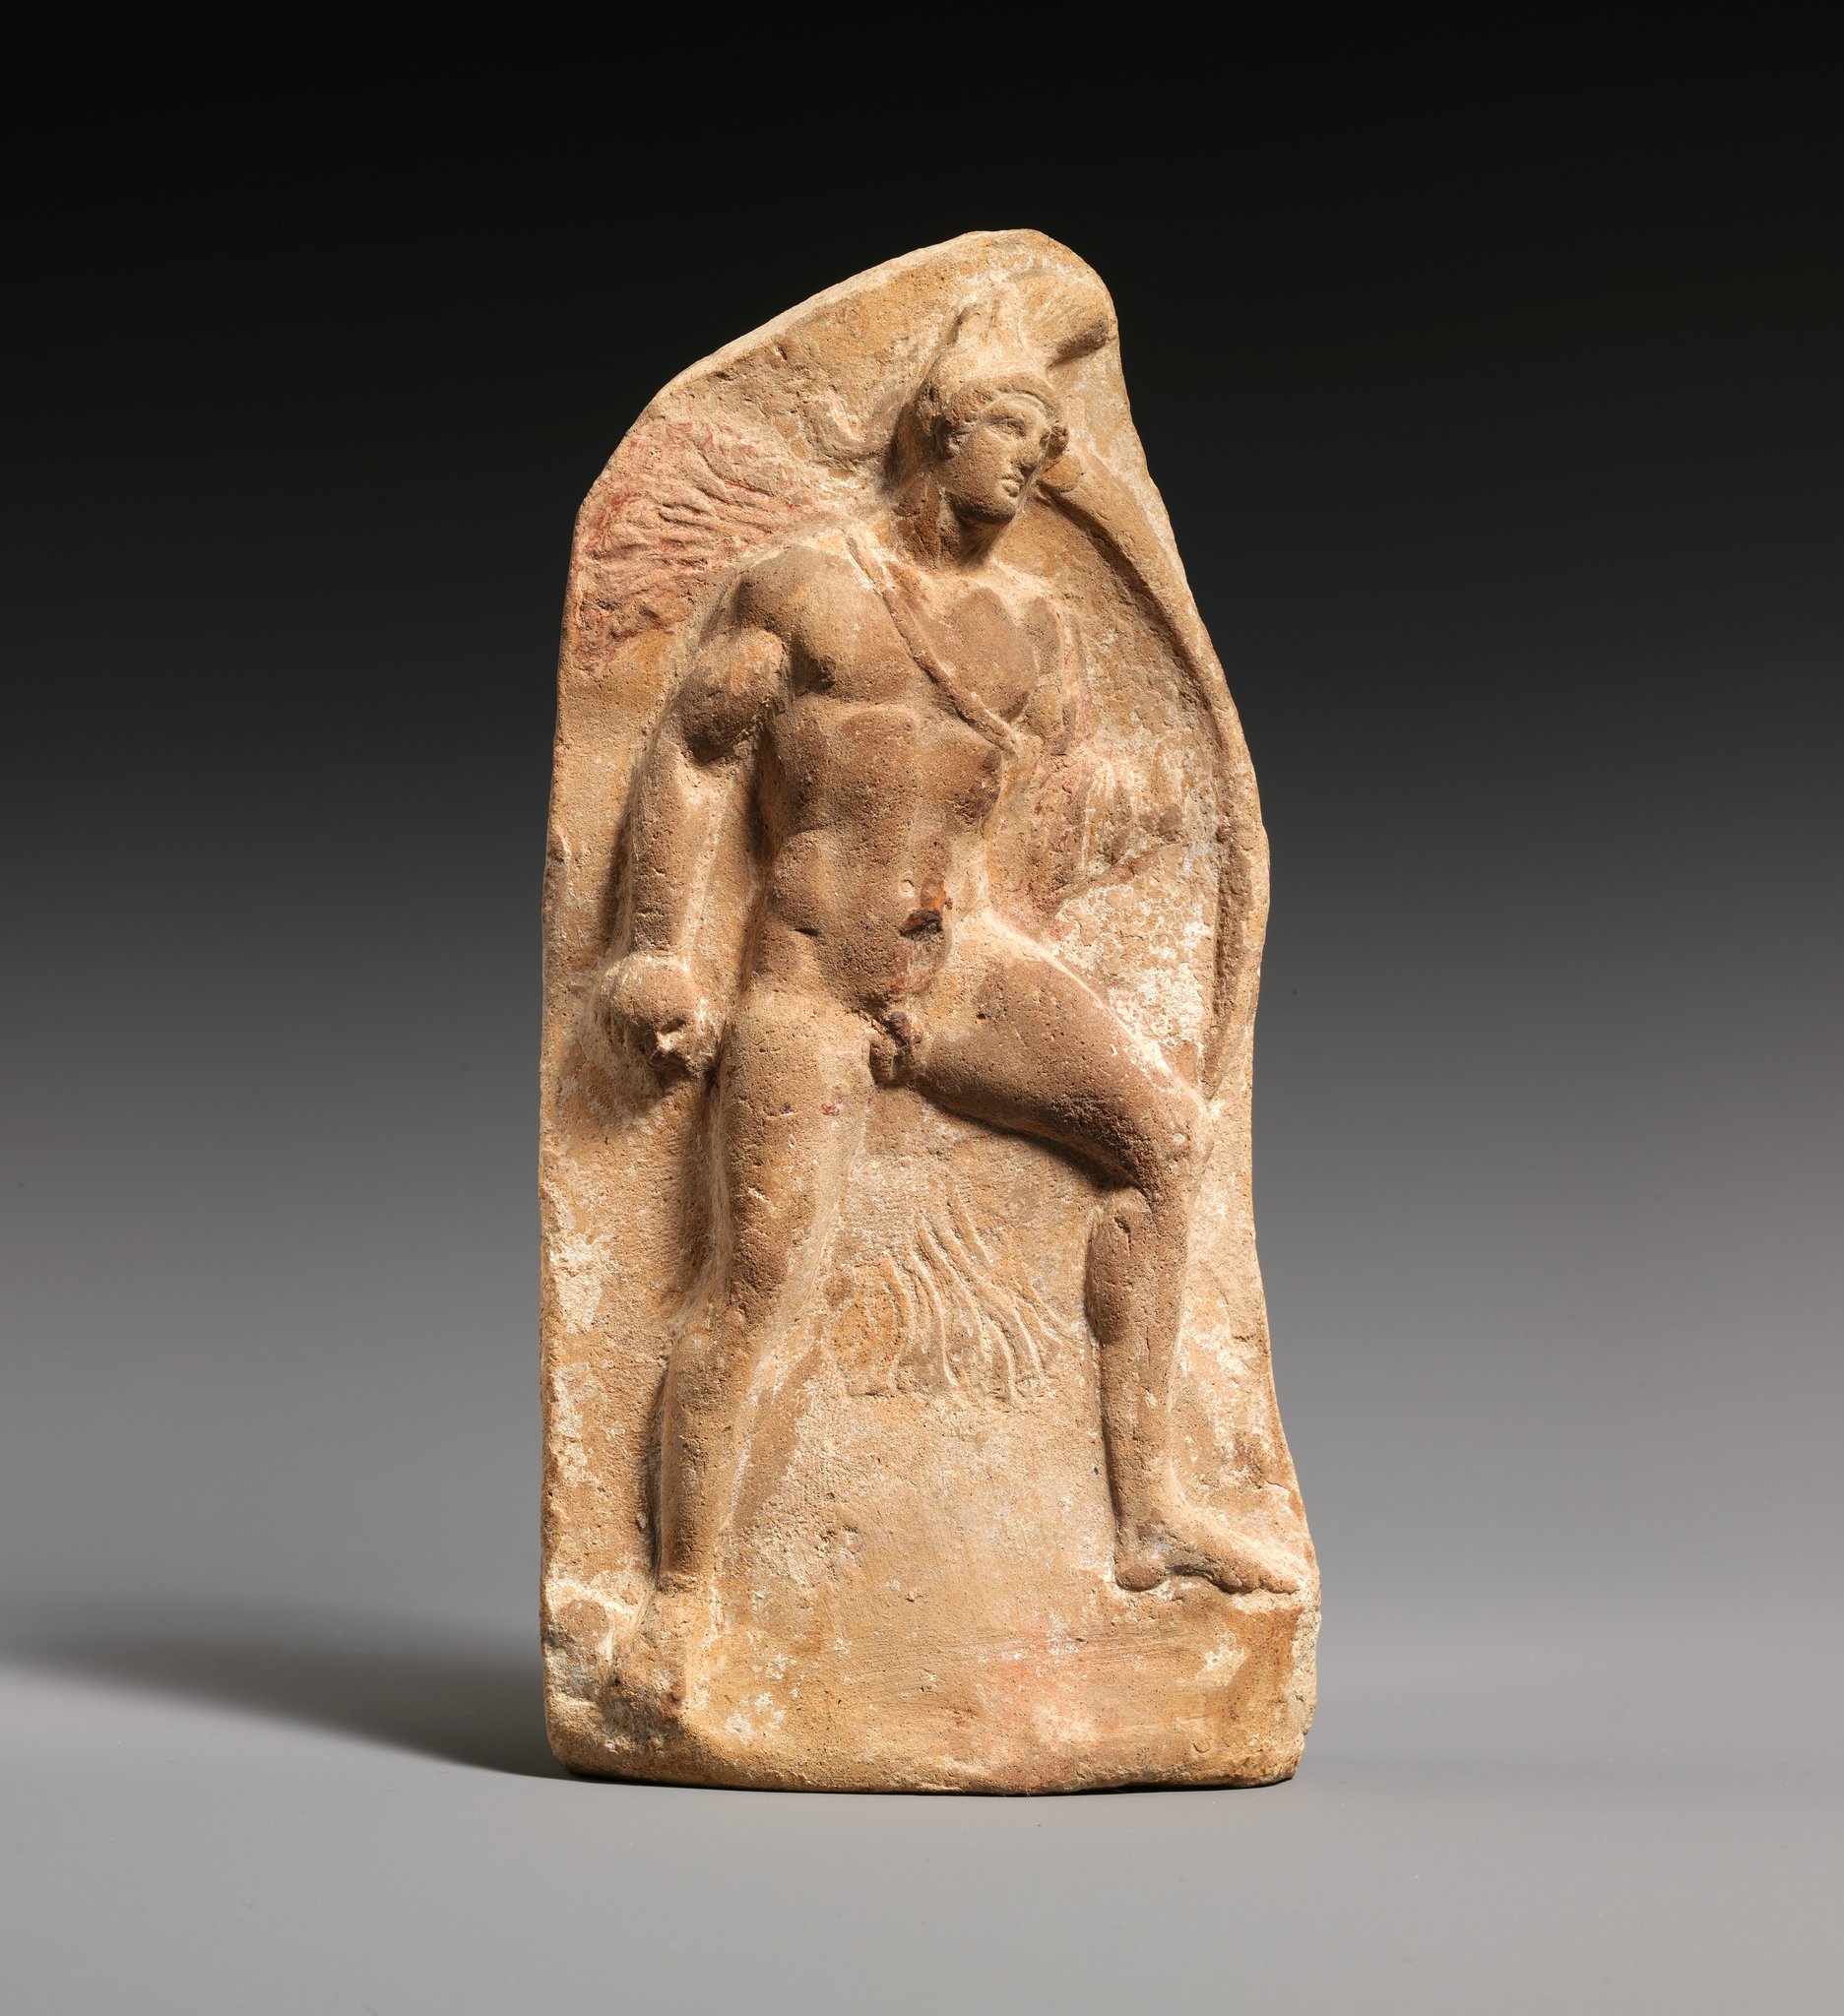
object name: relief of a warrior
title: Terracotta relief depicting a warrior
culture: cypriot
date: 100-1 BCE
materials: terracotta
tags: male nudes,warriors